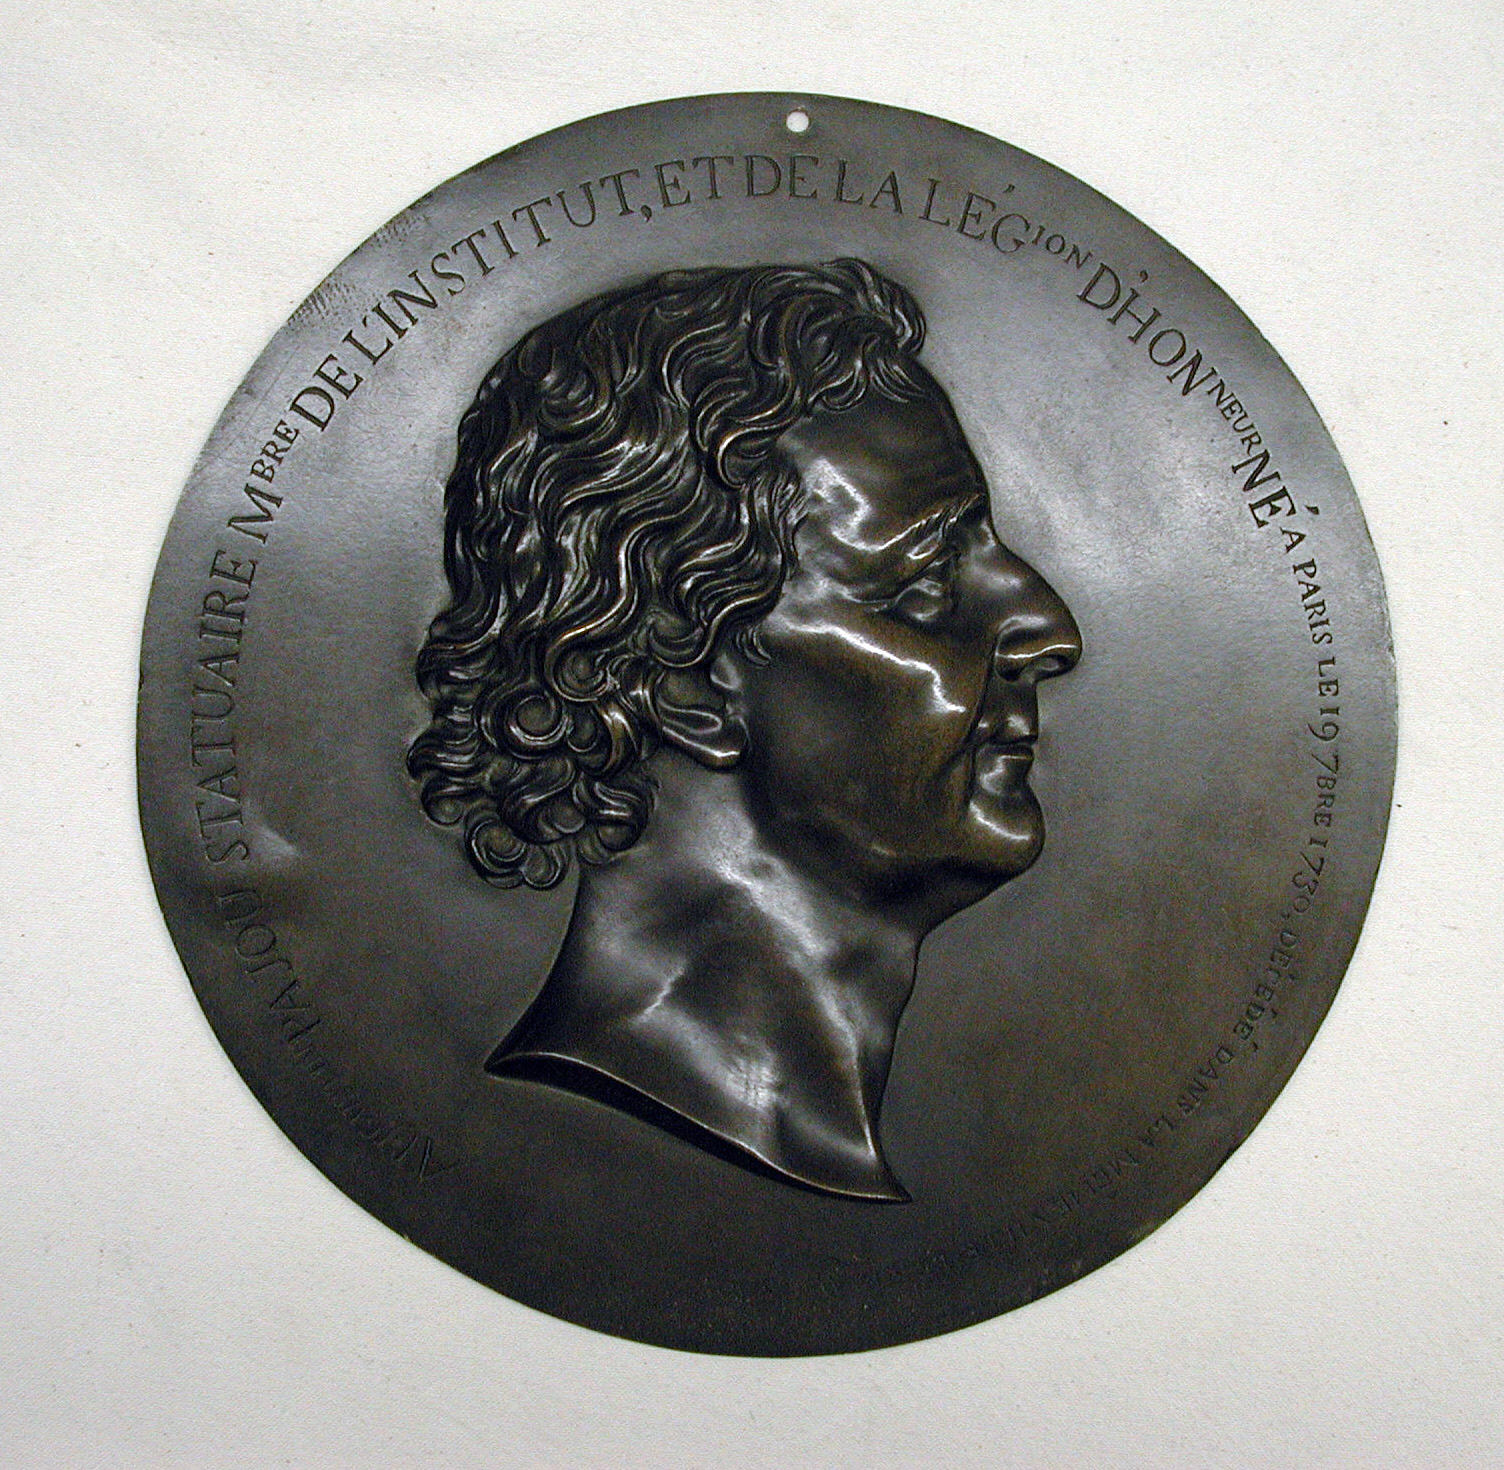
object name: medallion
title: Augustin Pajou (1730–1809)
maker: philippe laurent roland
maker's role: maker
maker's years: 1746-1816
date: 1803-1809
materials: bronze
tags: men,profiles